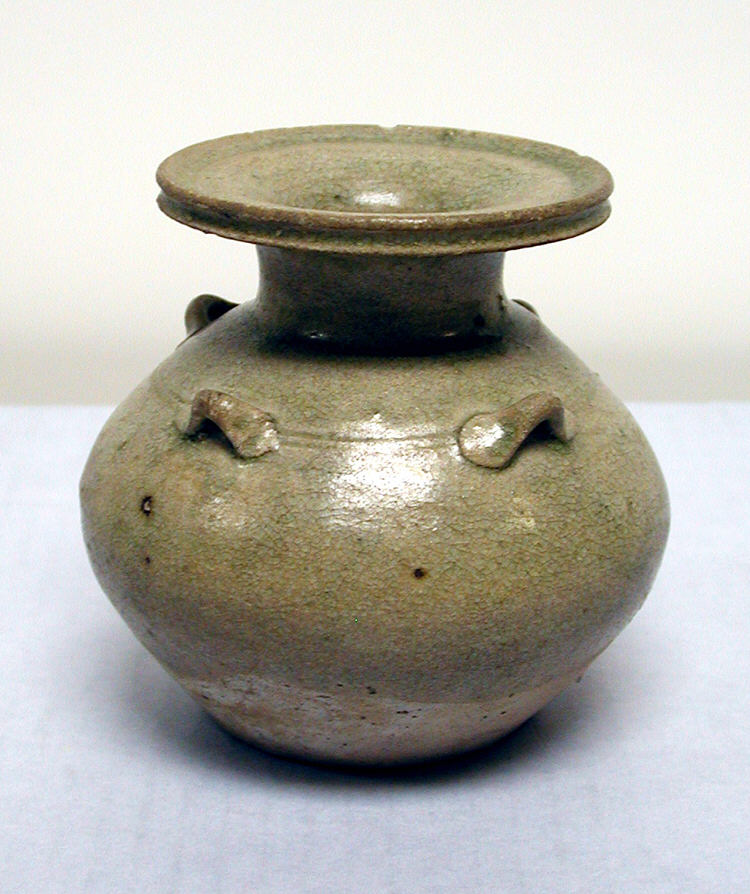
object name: jar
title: Jar (Hu)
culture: chinese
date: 267-400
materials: stoneware